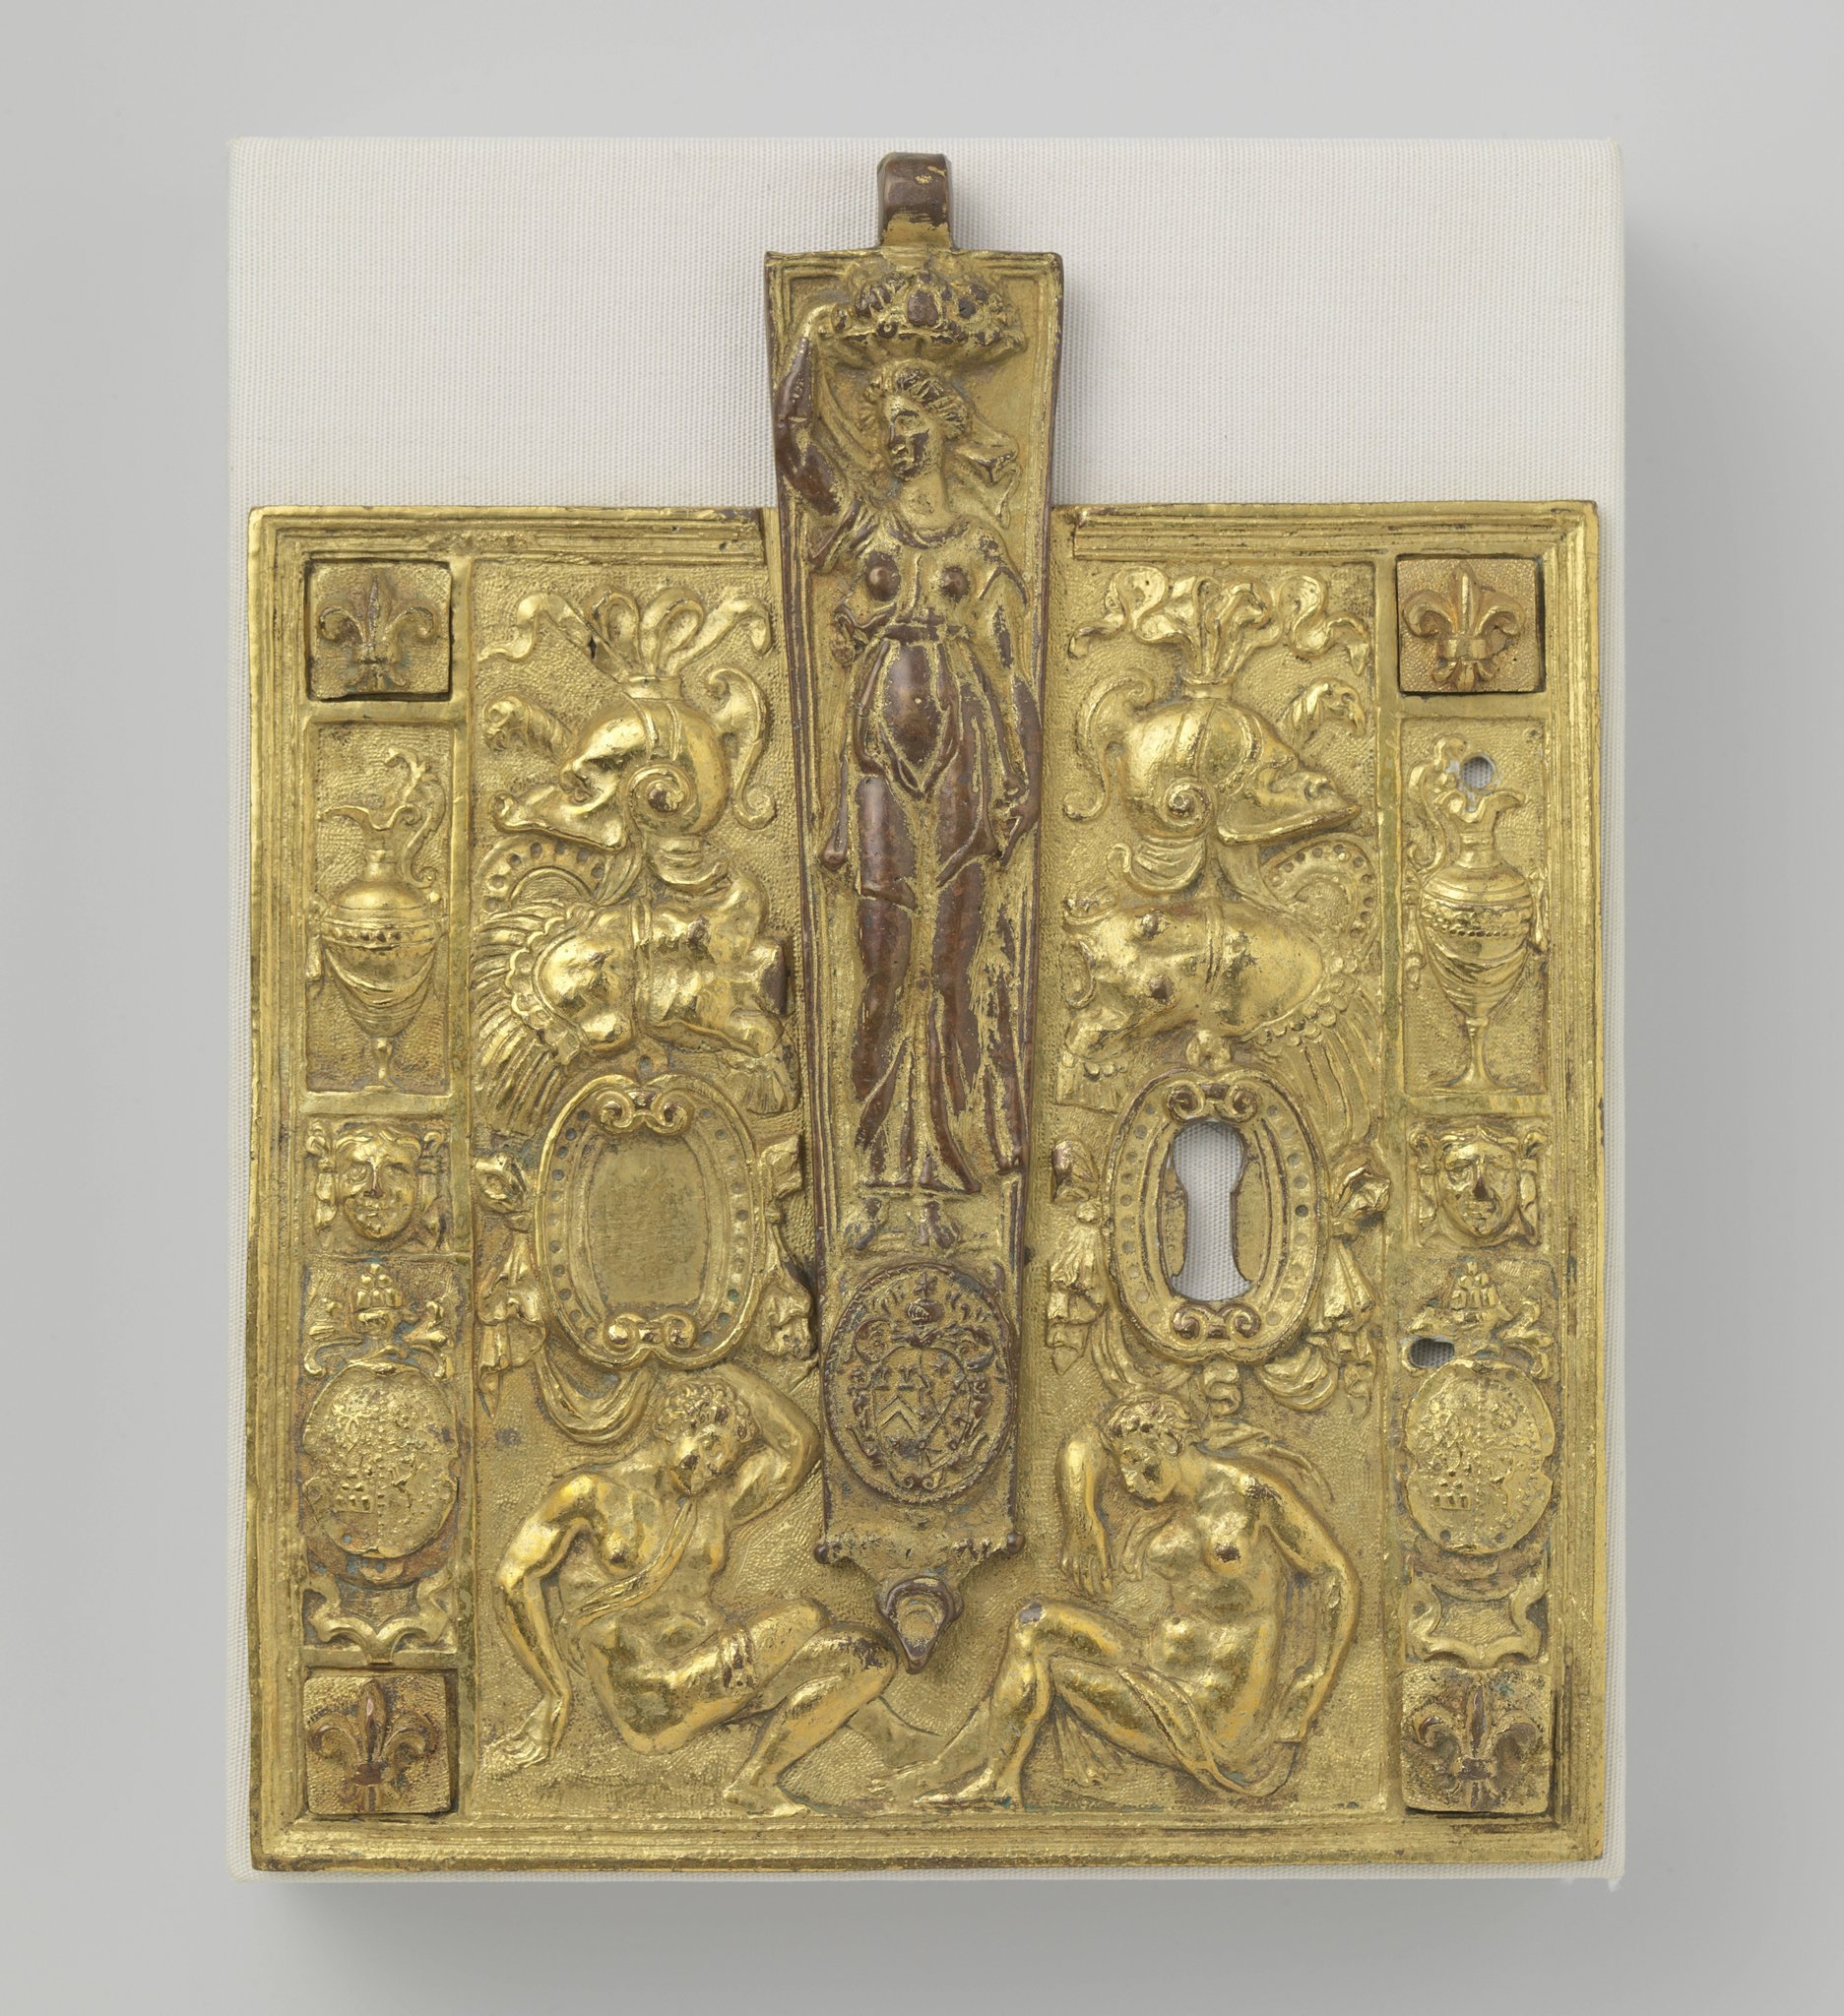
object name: slotplaat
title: Lock plate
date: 1550-1600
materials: copper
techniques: gilding, punching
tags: fleur-de-lis ~ ornament, mask, mascaron ~ ornament, carrying something on the head or on the shoulders, armorial bearing, heraldry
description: This lock plate was once the most decorative element on a travelling chest. On the hasp is the figure of a woman carrying a shell laden with fruits on her head. She symbolizes Abundance. Flanking the hasp are trophies of armour and two seated female figures. Some ten examples of such richly decorated lock plates are known, most bearing the escutcheons of leading Italian families.